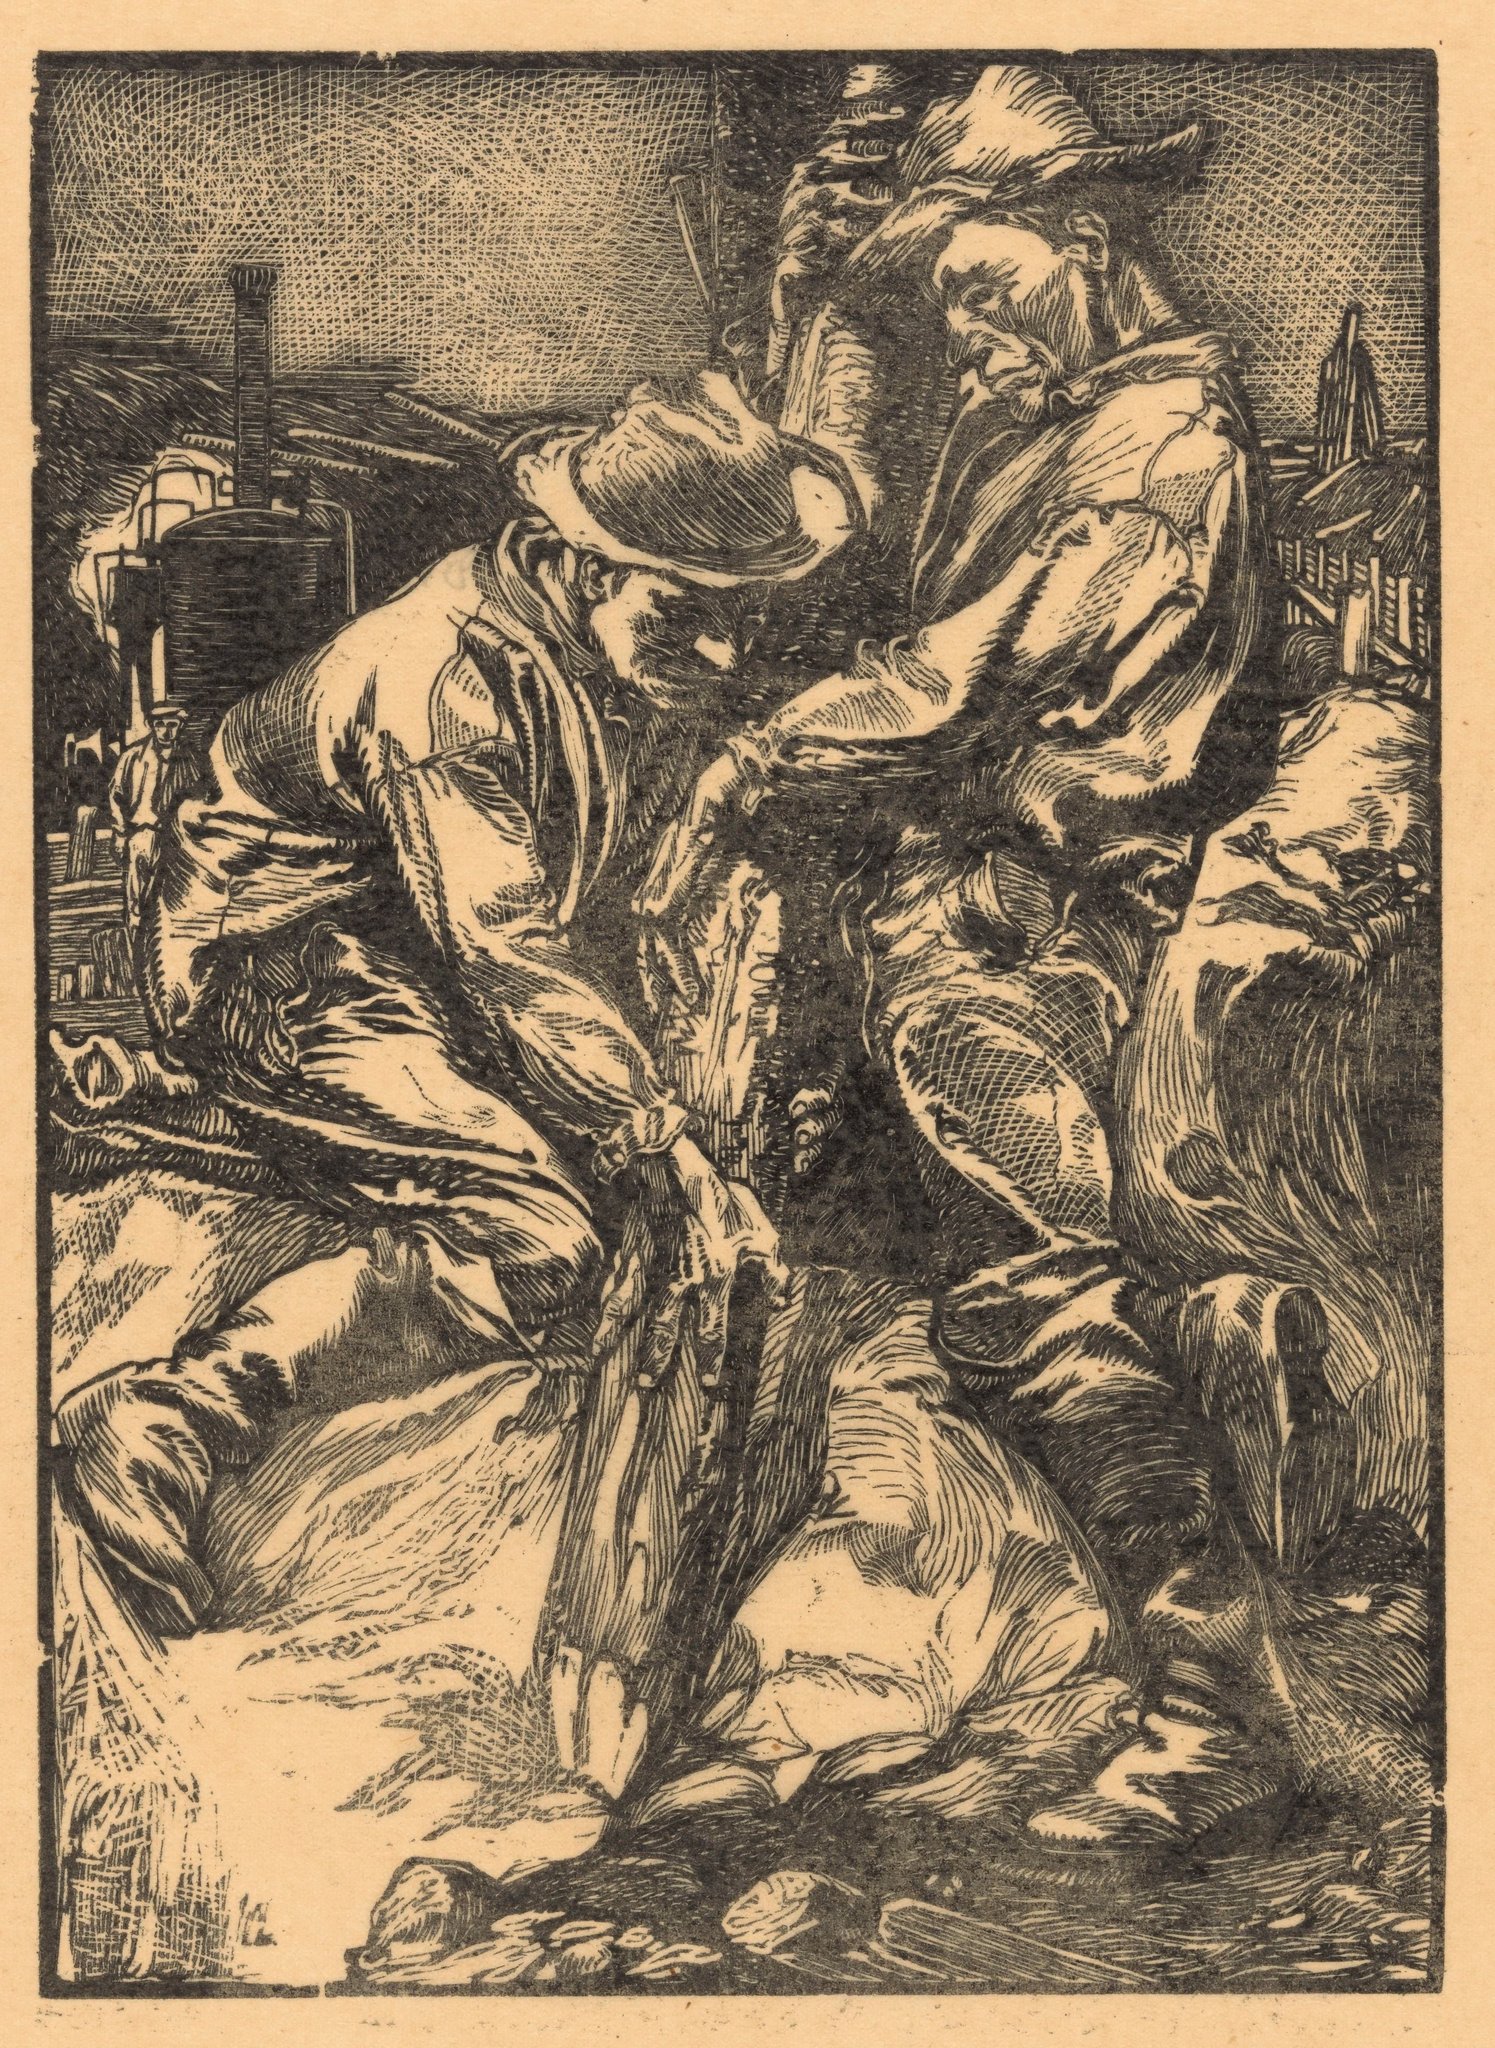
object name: print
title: Heiende polderjongens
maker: johannes josephus aarts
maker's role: draughtsman, print maker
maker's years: 1871-1934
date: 1881-1934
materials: paper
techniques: woodcut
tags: ramming, driving piles (~ building activities), working class, labourers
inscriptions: collector's mark: Lugt 2228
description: Twee arbeiders plaatsen samen een paal in de grond. Ze dragen beiden een hoed. Linksachter hen een machine en een andere arbeider.